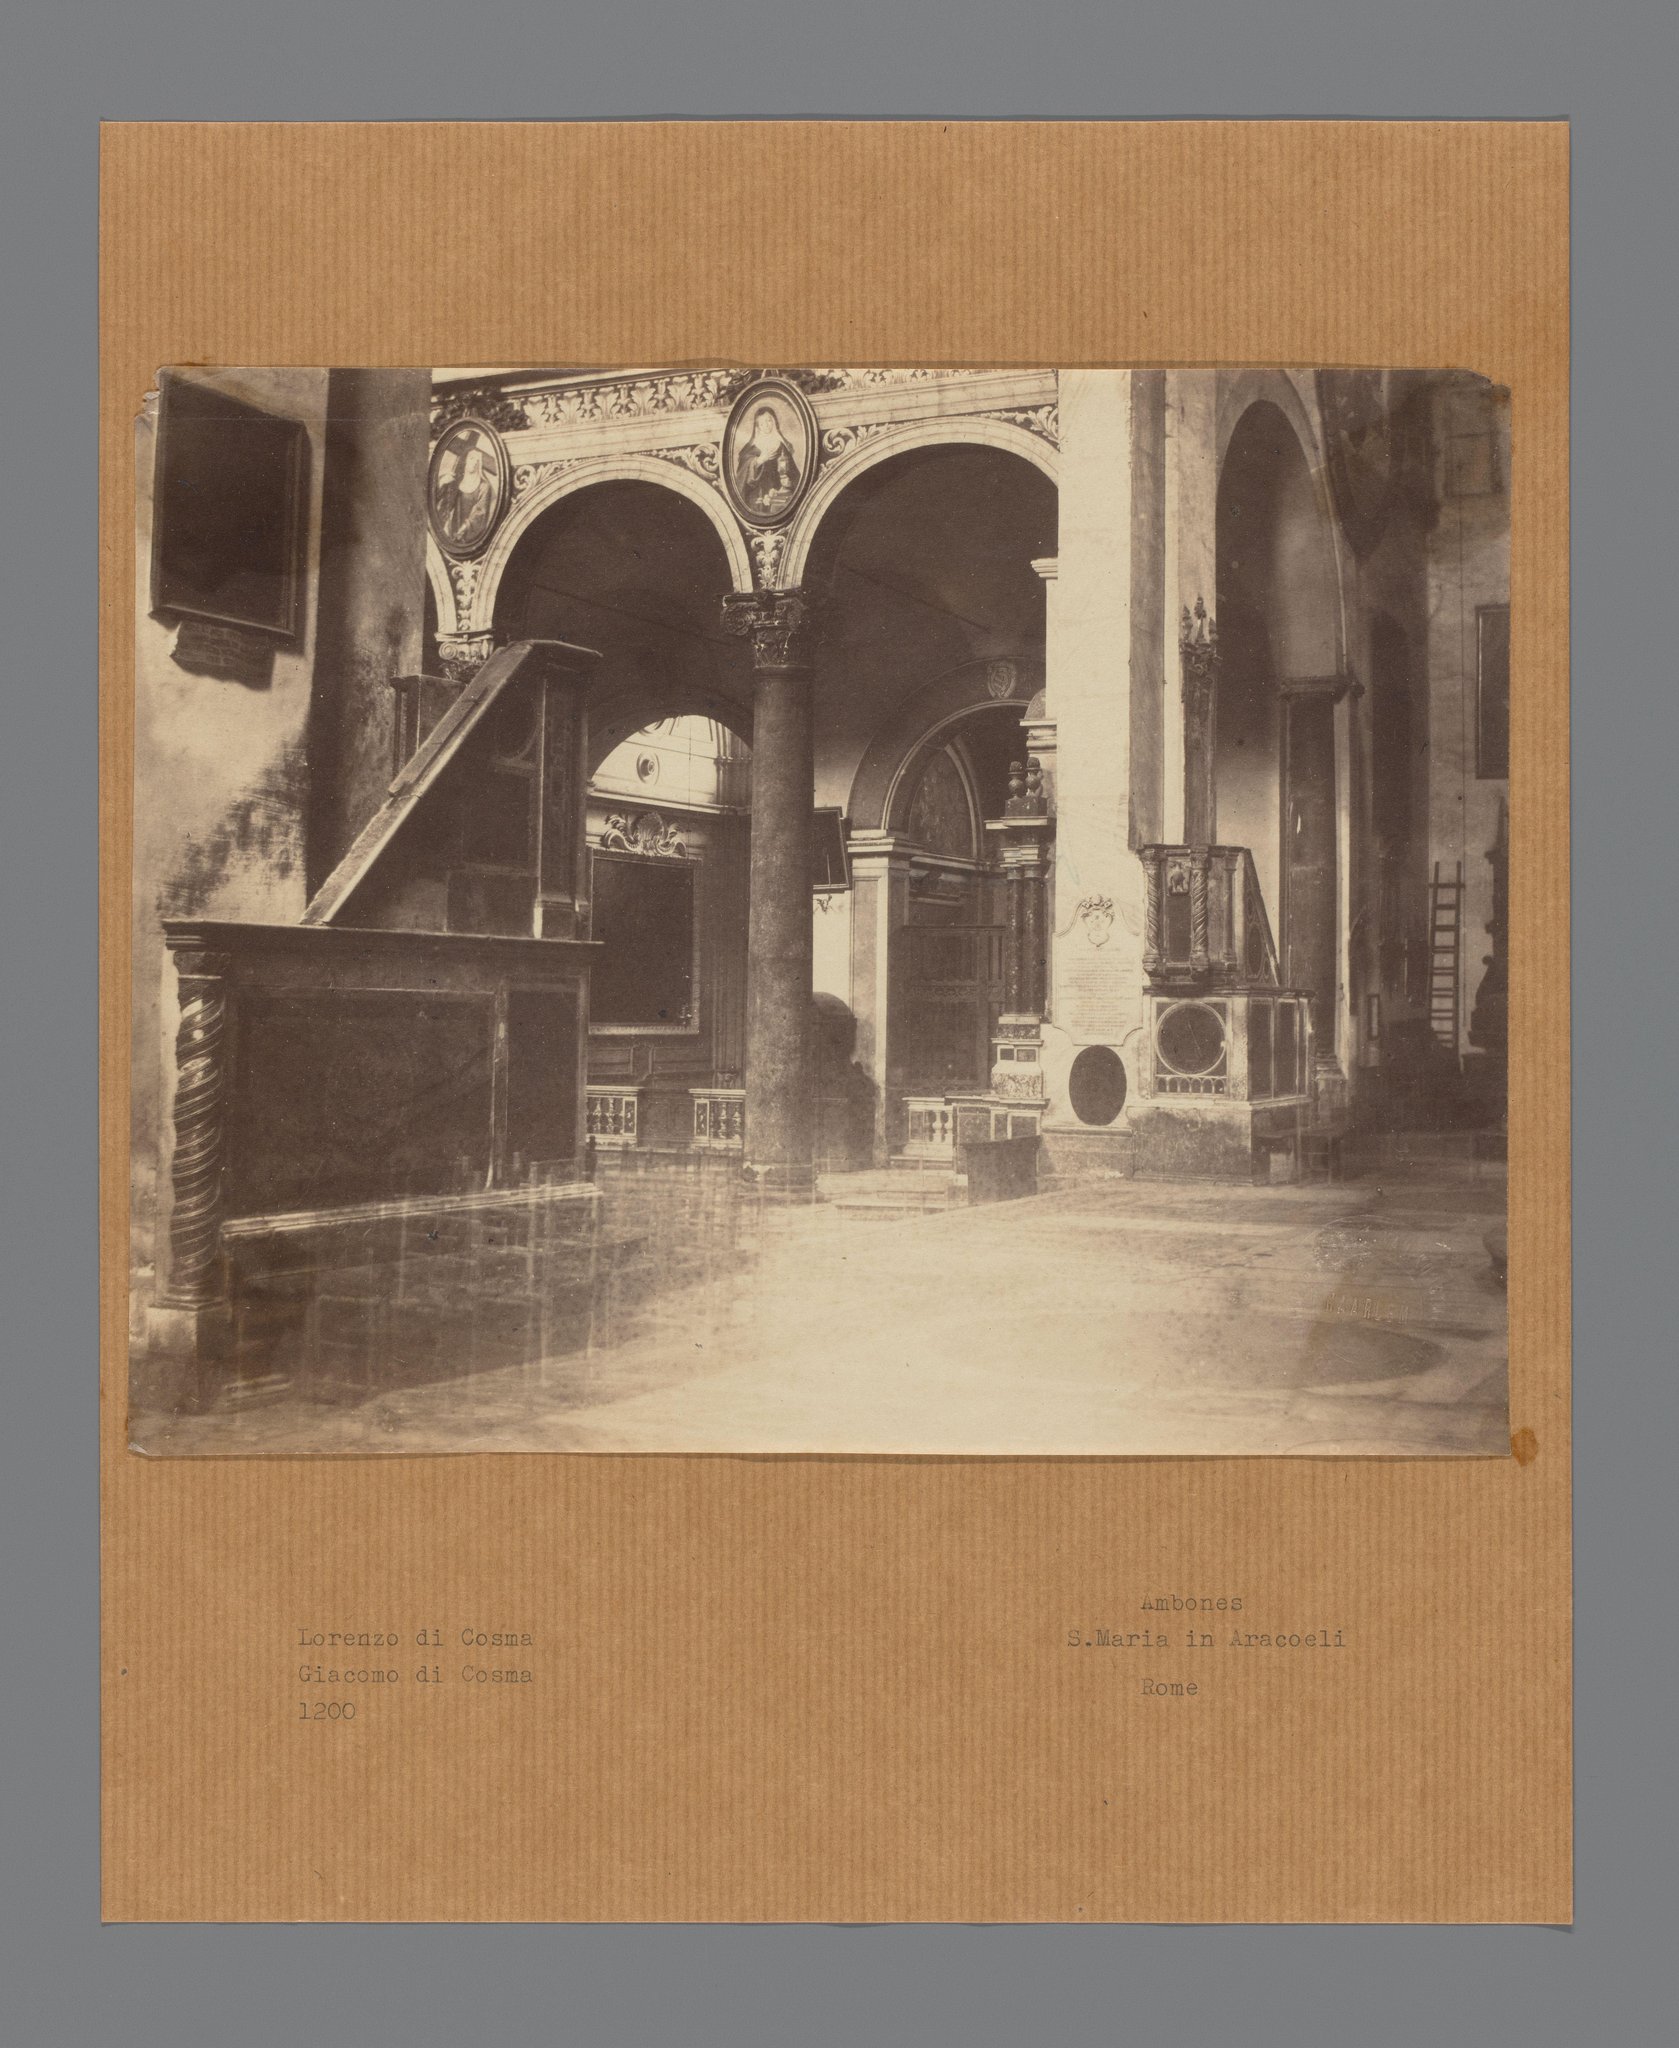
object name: photograph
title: S. Maria in Aracoeli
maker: Anonymous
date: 1850-1899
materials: paper, photographic support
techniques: albumen print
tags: santa maria in aracoeli